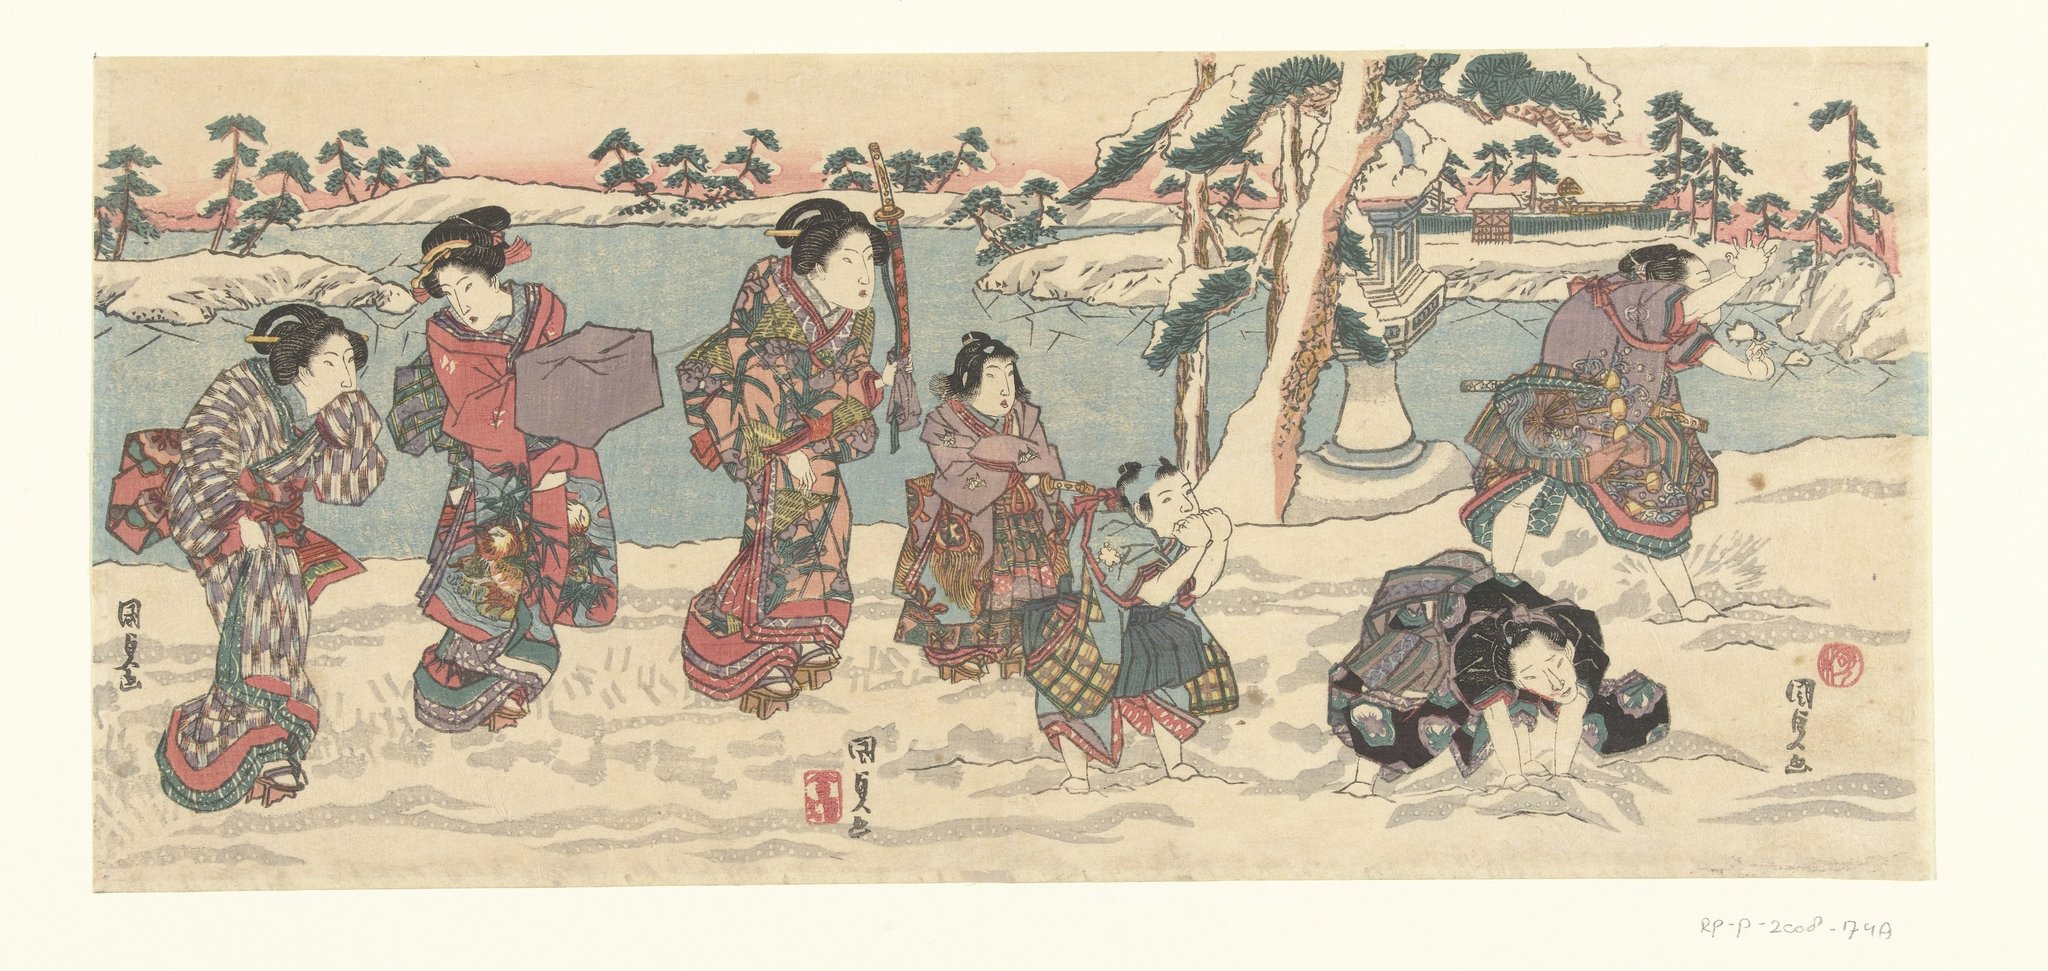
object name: print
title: Sneeuwballen gooien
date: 1825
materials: paper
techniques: woodcut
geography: japan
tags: throwing snowballs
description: Sneeuwlandschap met drie vrouwen en twee kinderen kijkend naar twee mannen, waarvan de één gebukt staat met zijn handen in de sneeuw, terwijl de ander zojuist een sneeuwbal gegooid heeft. In de achtergrond een bevroren meer, in de sneeuw op de voorgrond diverse afdrukken van voetstappen.